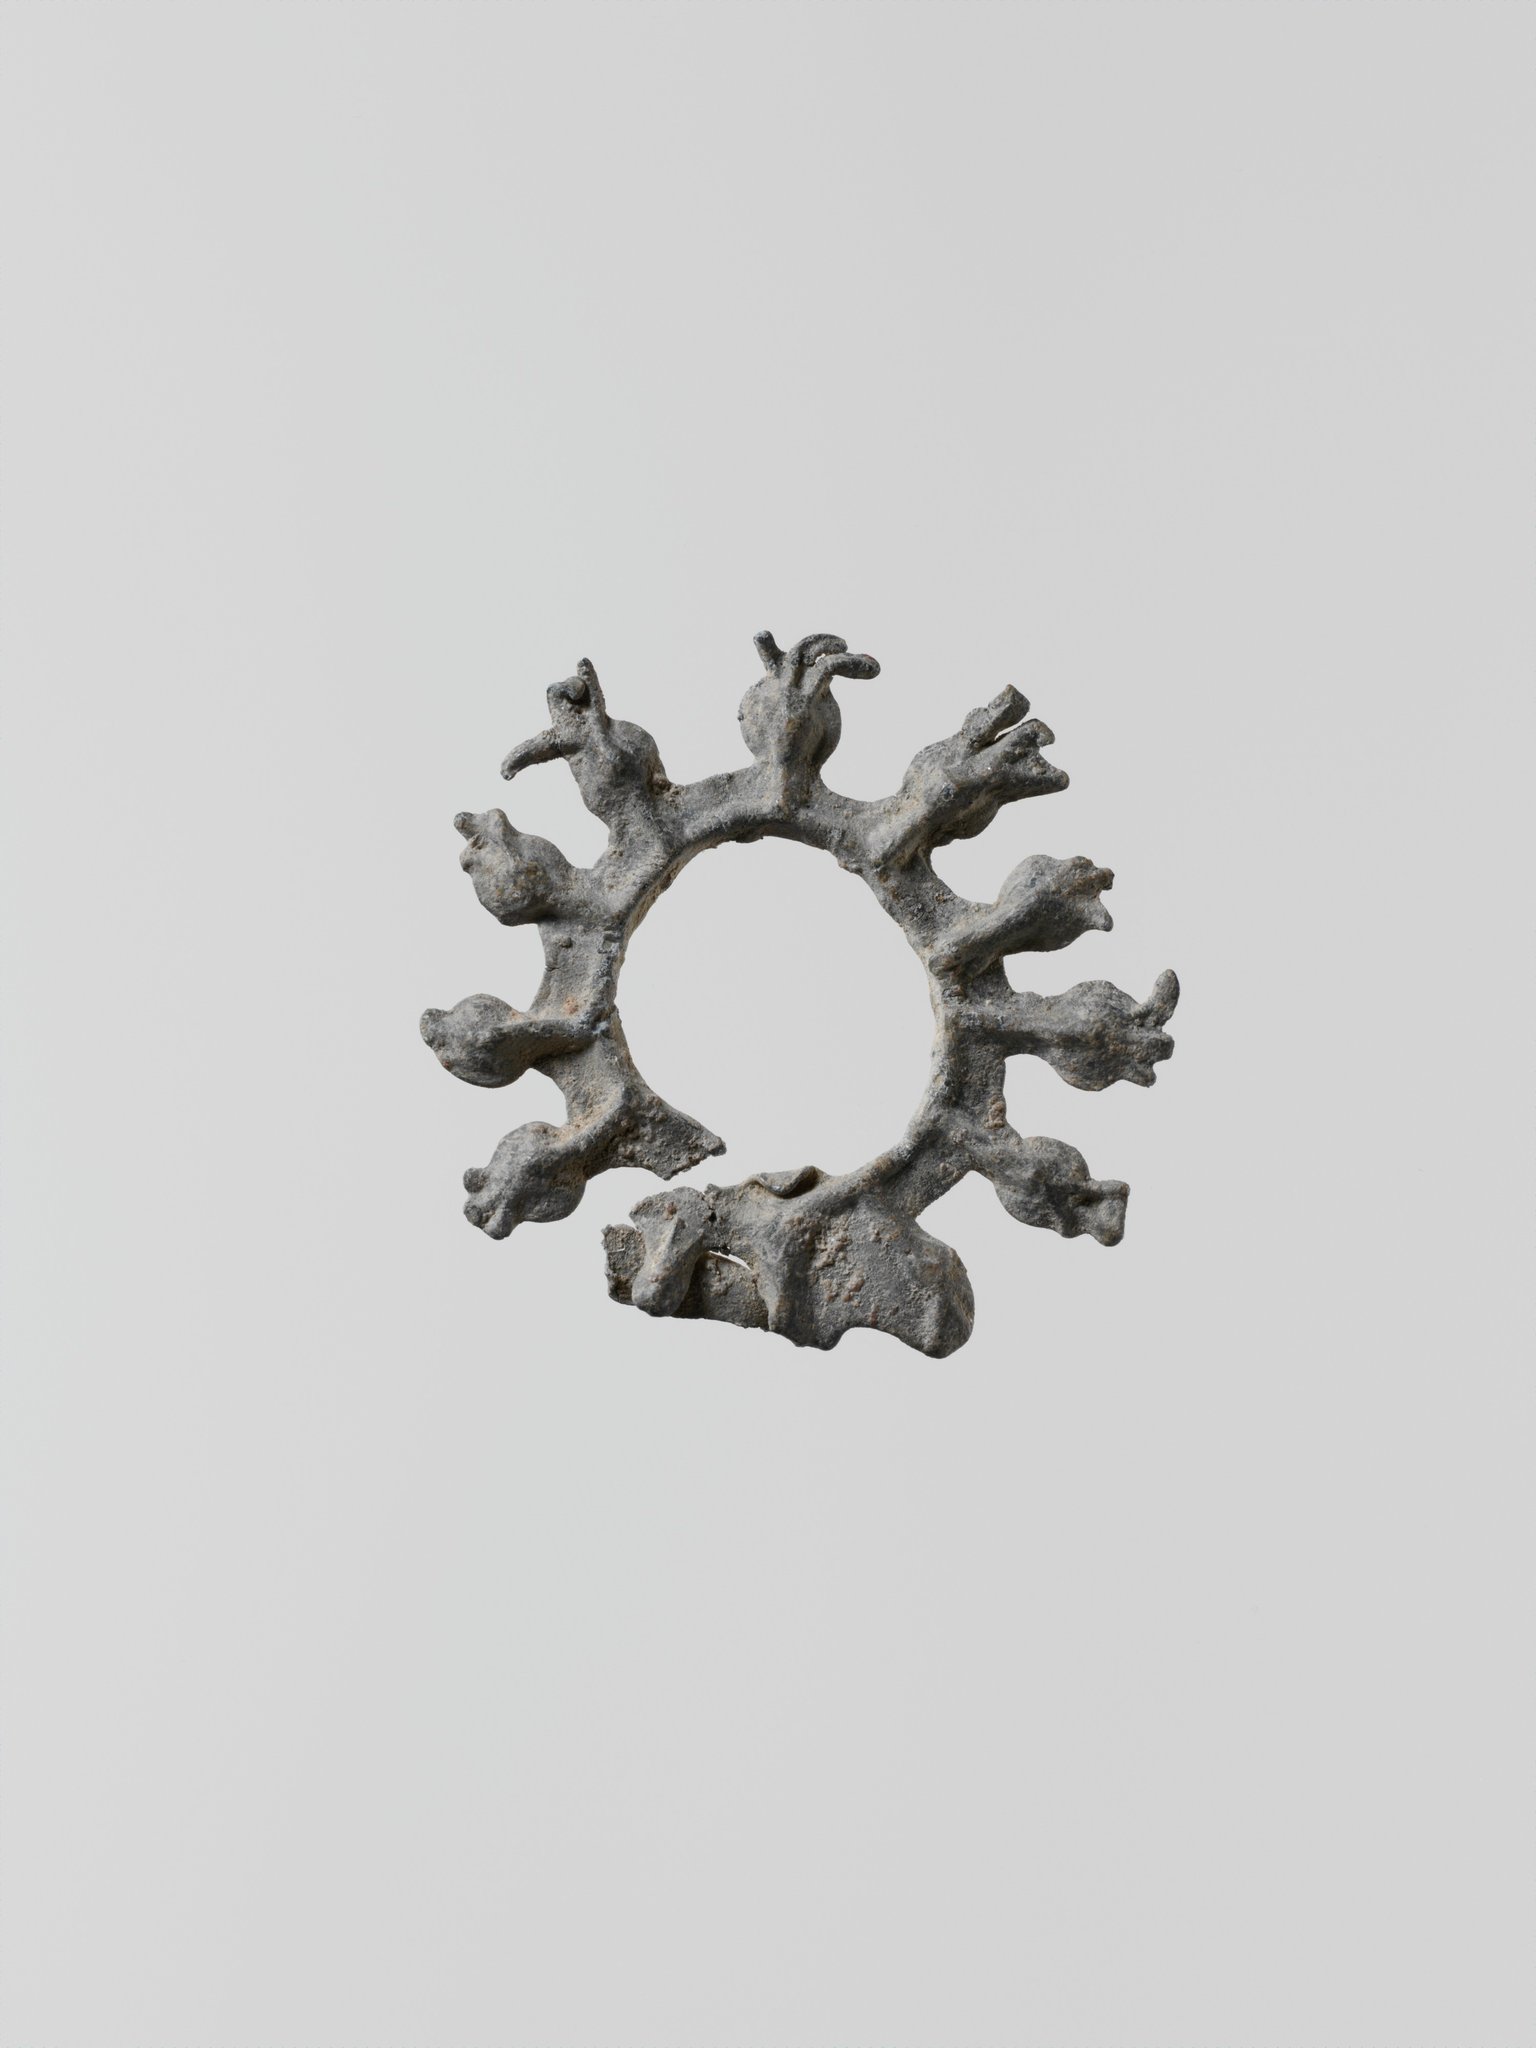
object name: wreath, 6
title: Lead wreath of lotus buds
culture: greek, laconian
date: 600-401 BCE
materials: lead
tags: lotuses,wreaths